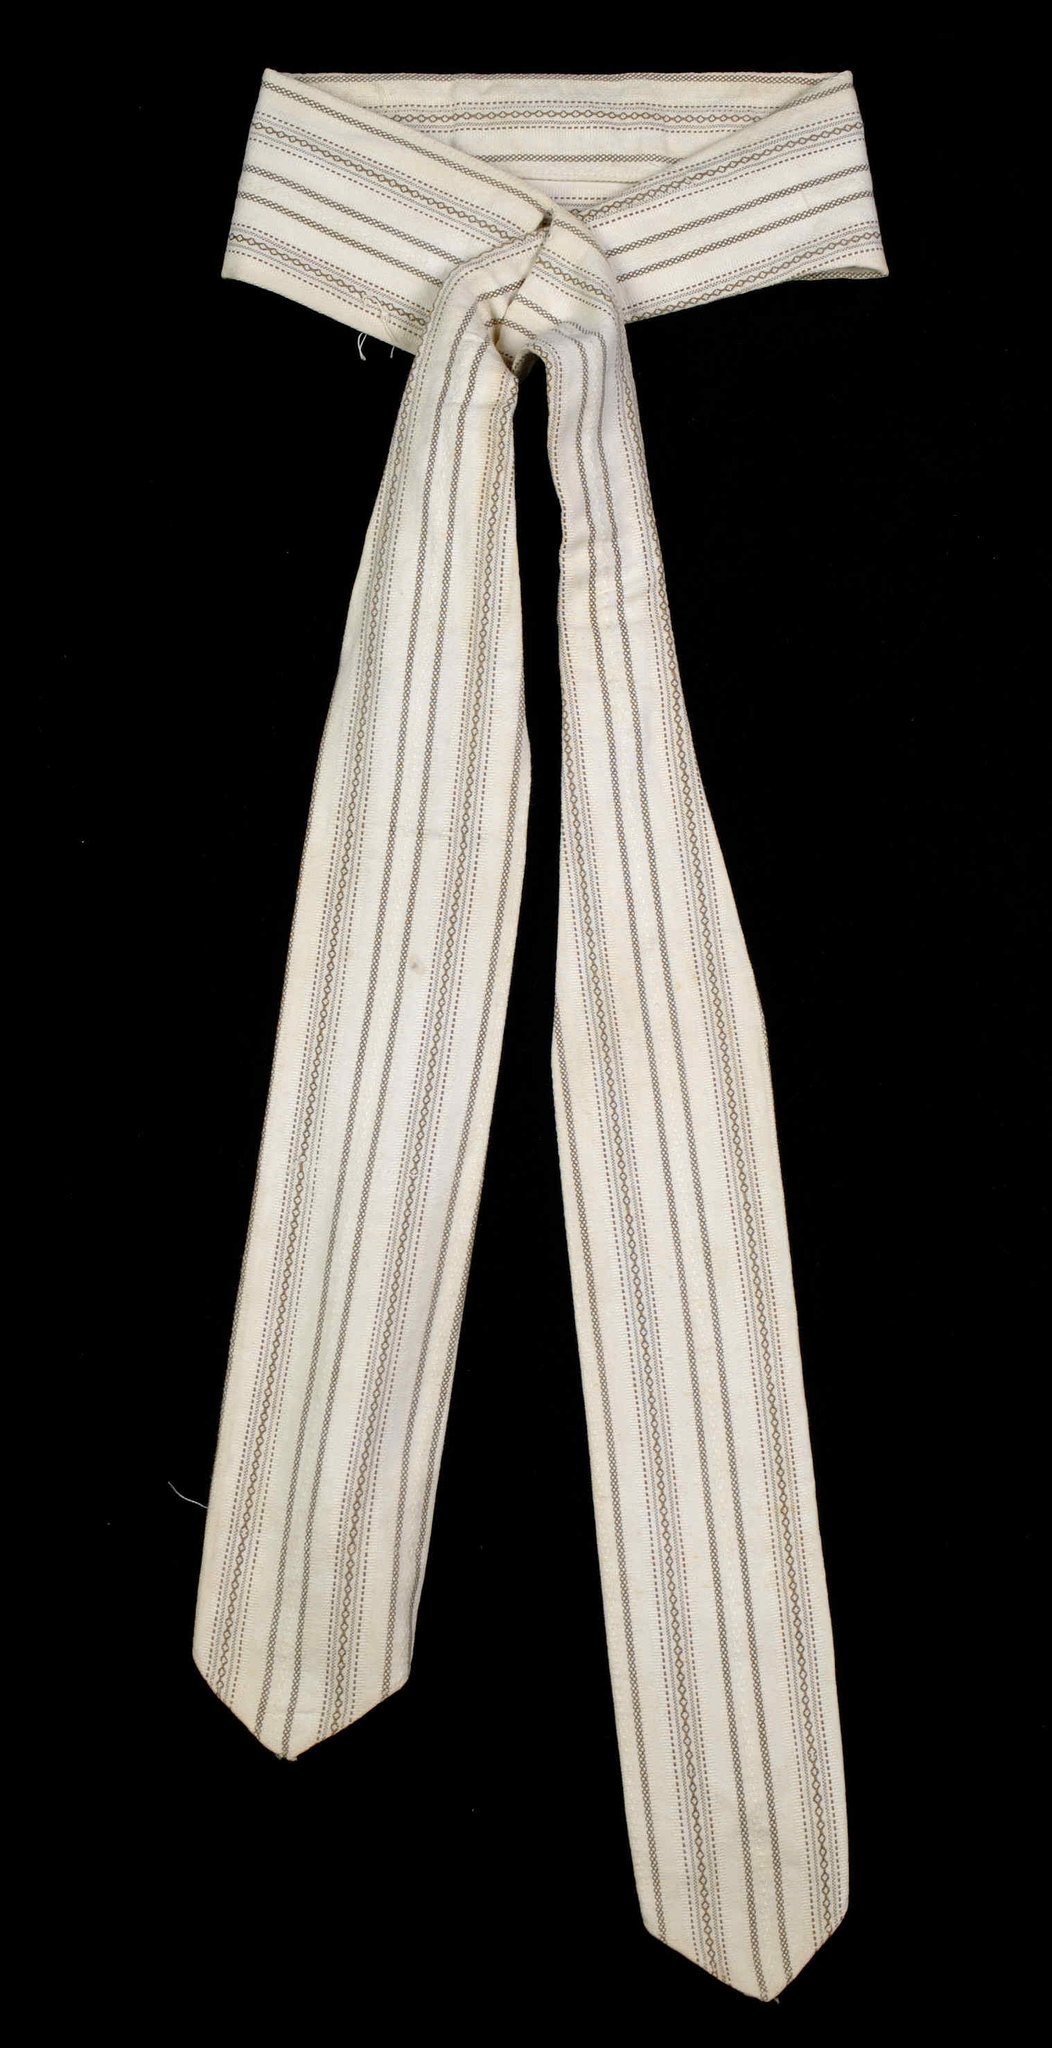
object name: cravat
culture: american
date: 1888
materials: cotton